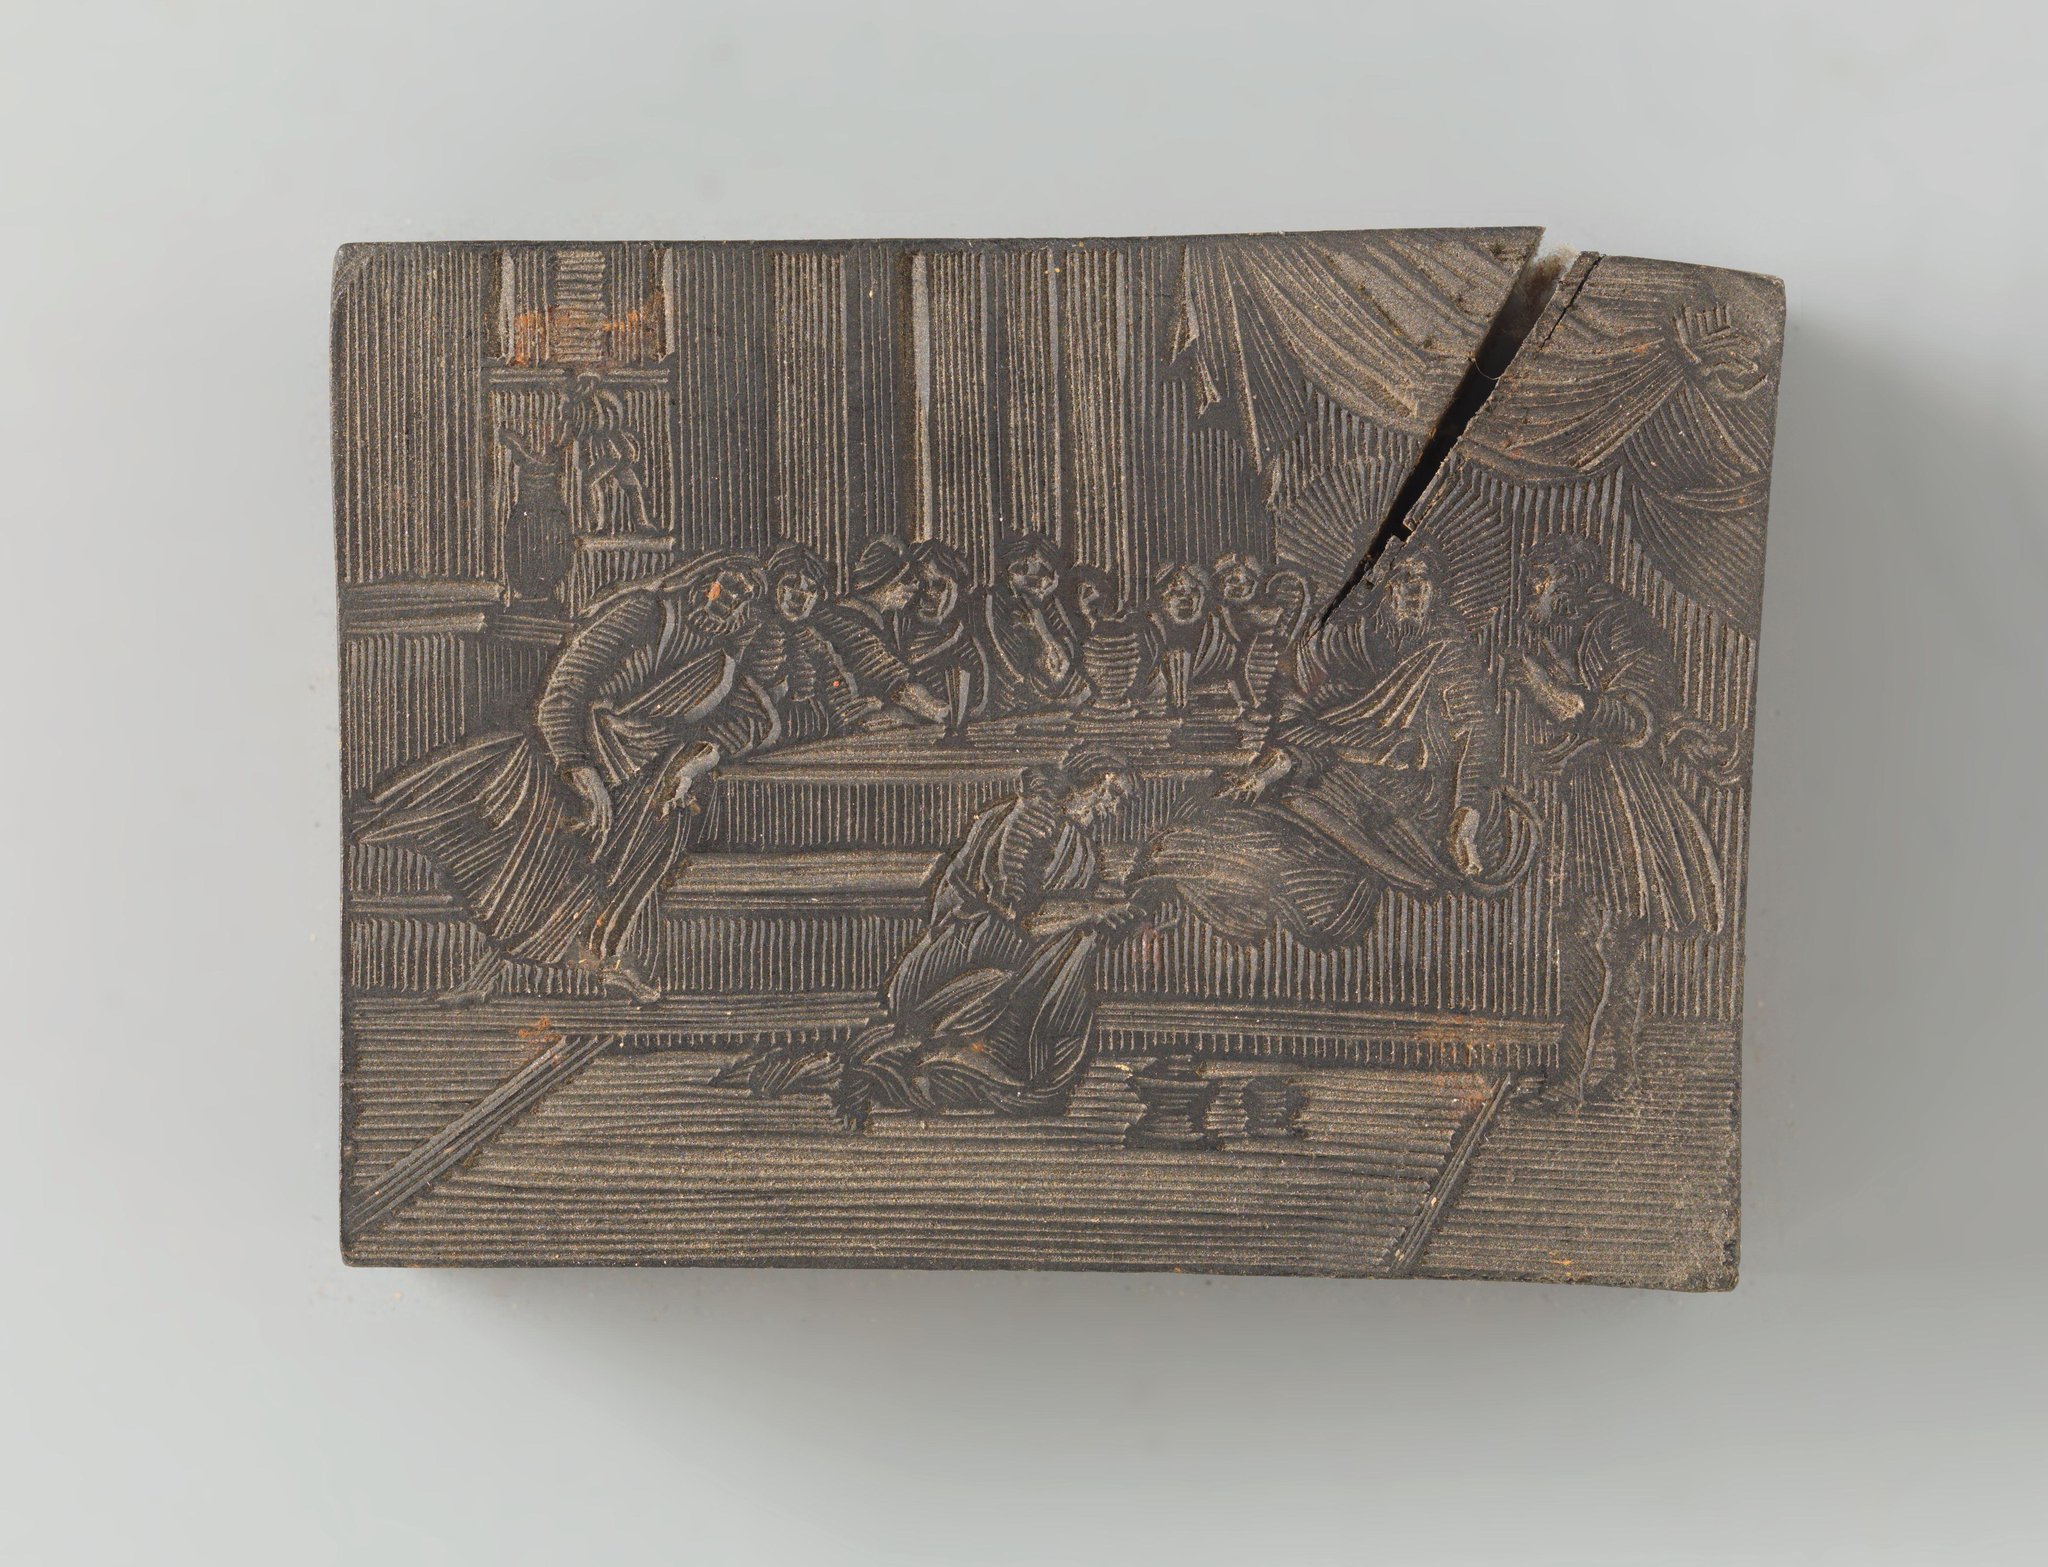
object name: wood block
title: Bijbel-illustraties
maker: Anonymous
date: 1550-1699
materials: wood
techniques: woodcut